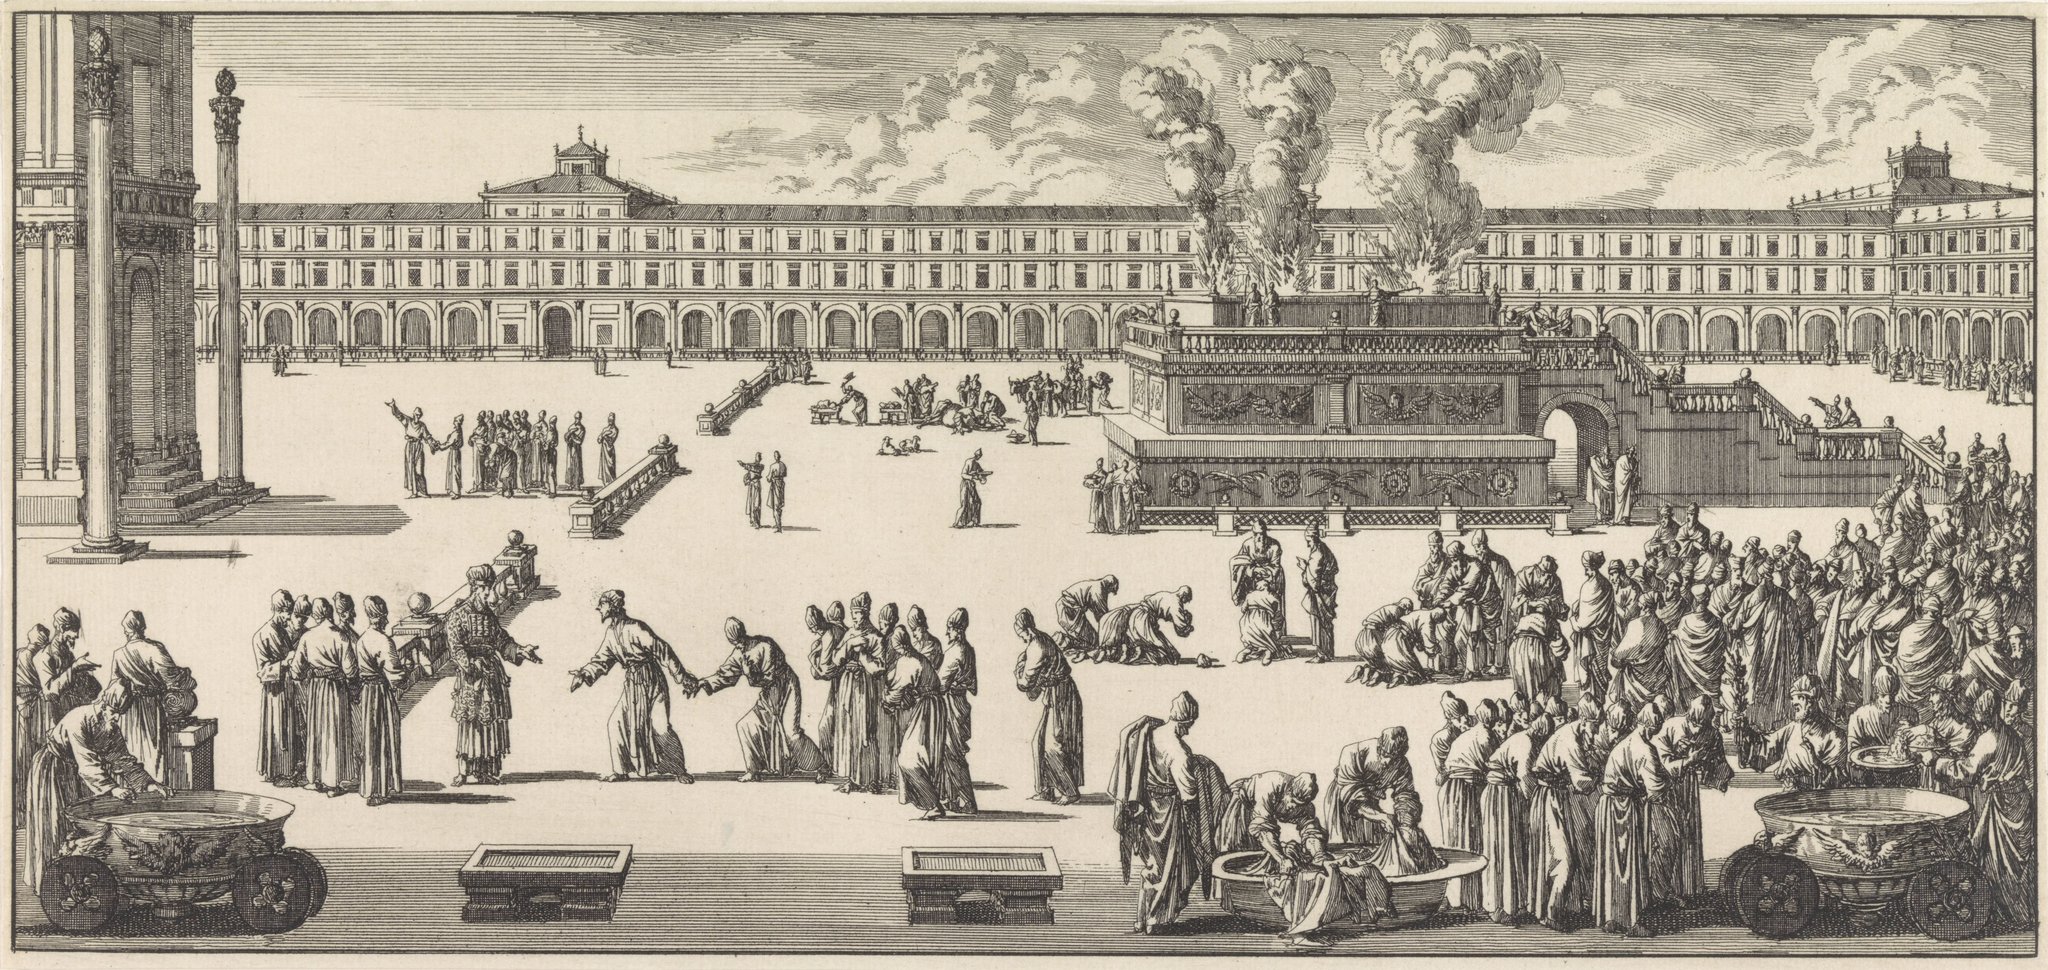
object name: print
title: Wijding van de Levieten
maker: jan luyken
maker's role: draughtsman, print maker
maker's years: 1649-1712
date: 1705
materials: paper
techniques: etching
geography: amsterdam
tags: the levites are appointed to serve the priests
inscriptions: collector's mark: Lugt 2228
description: Proefdruk van illustratie uit: Cunaeus, Petrus. La republique des Hebreux, 3 delen. Amsterdam: Pieter Mortier, 1705, dl. III. p. 57.